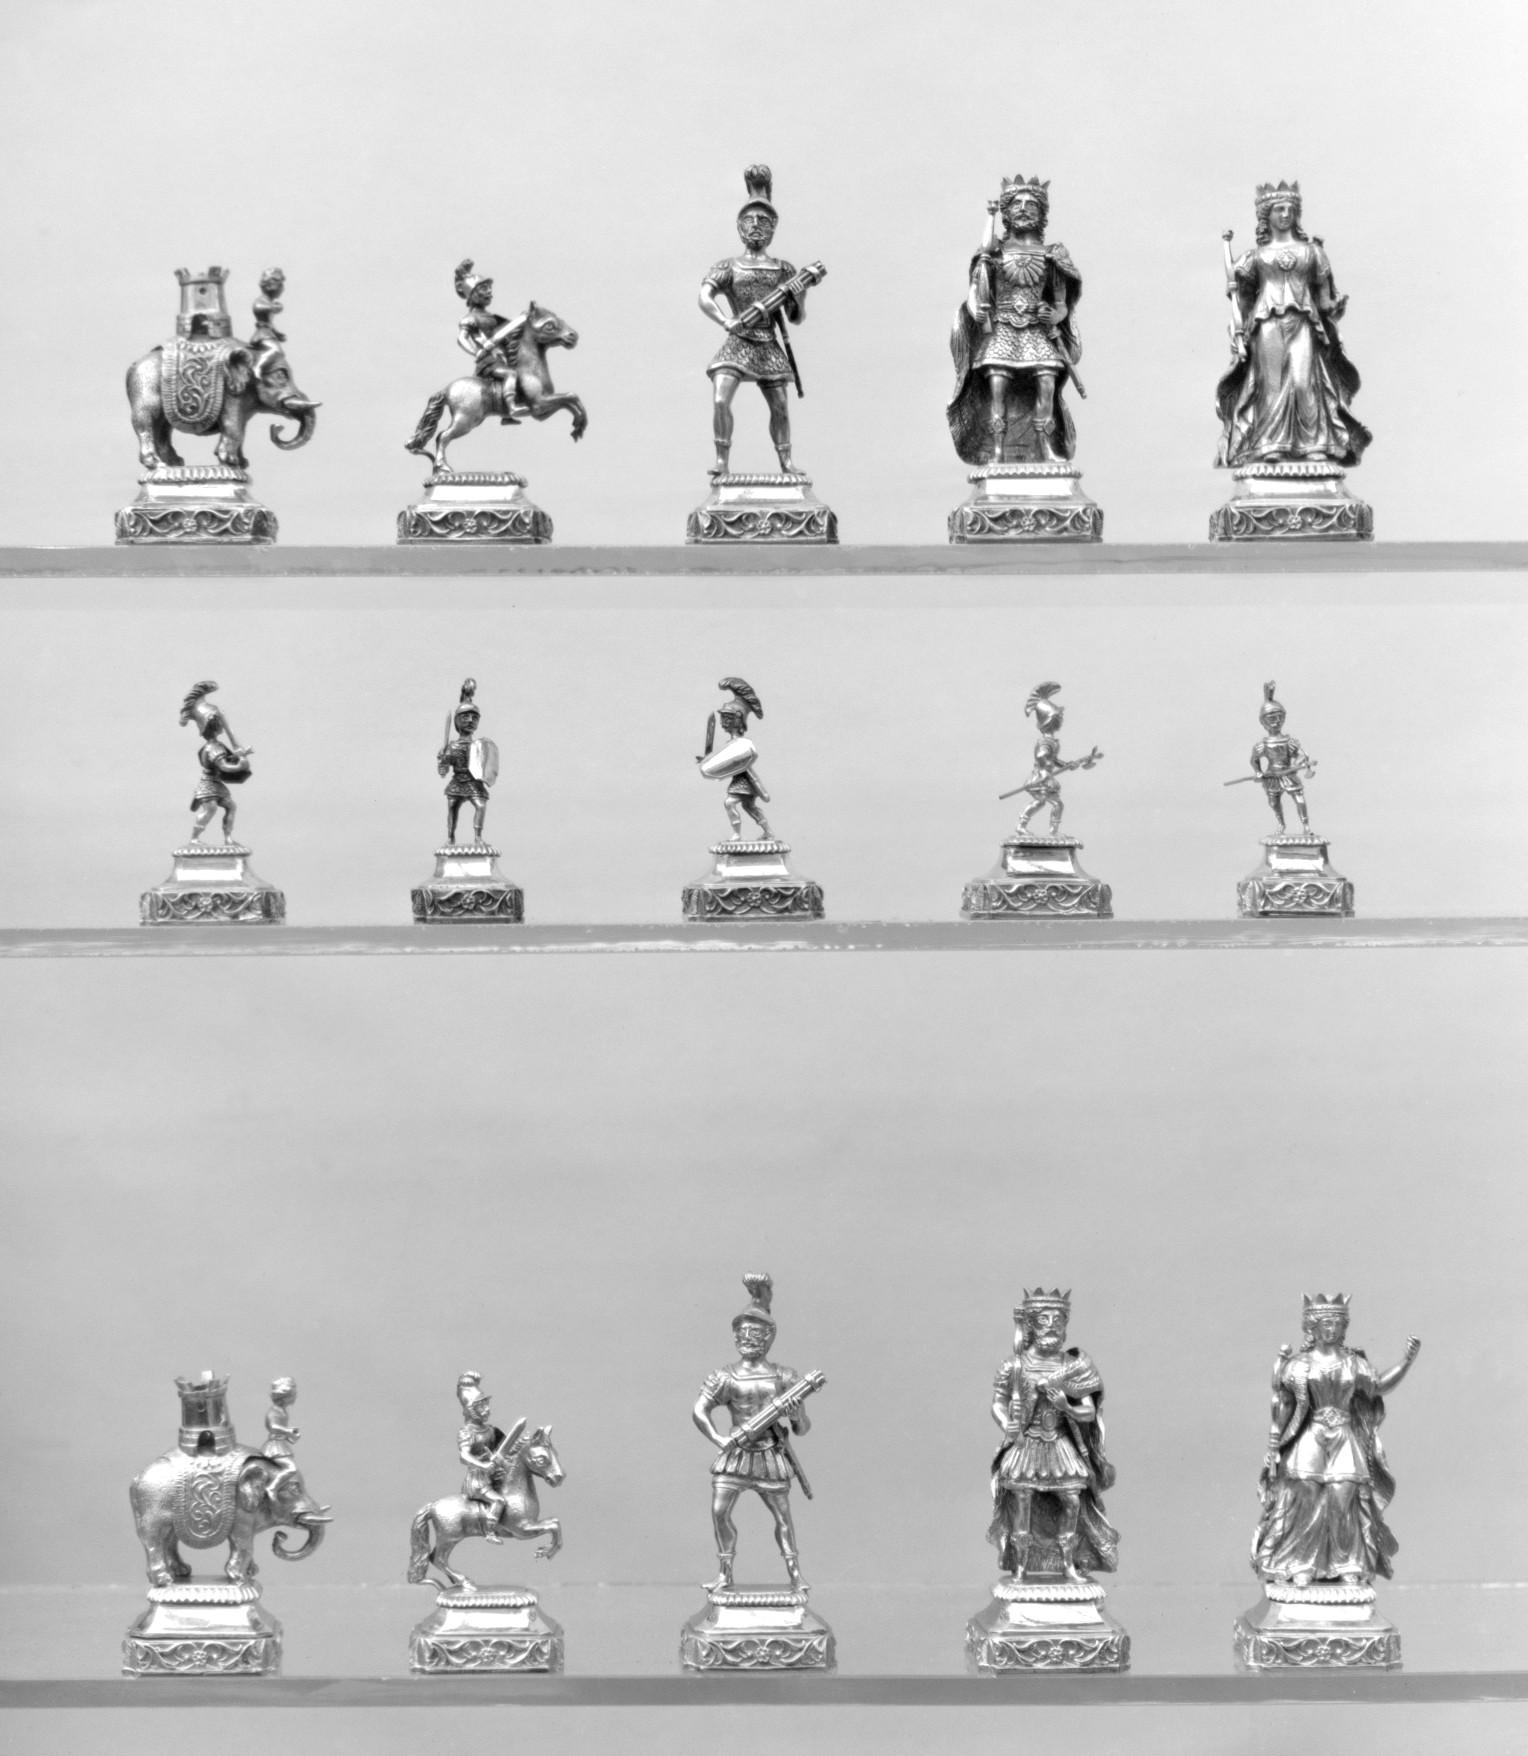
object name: chess set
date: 1830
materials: mother of pearl, silver, silver gilt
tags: chess